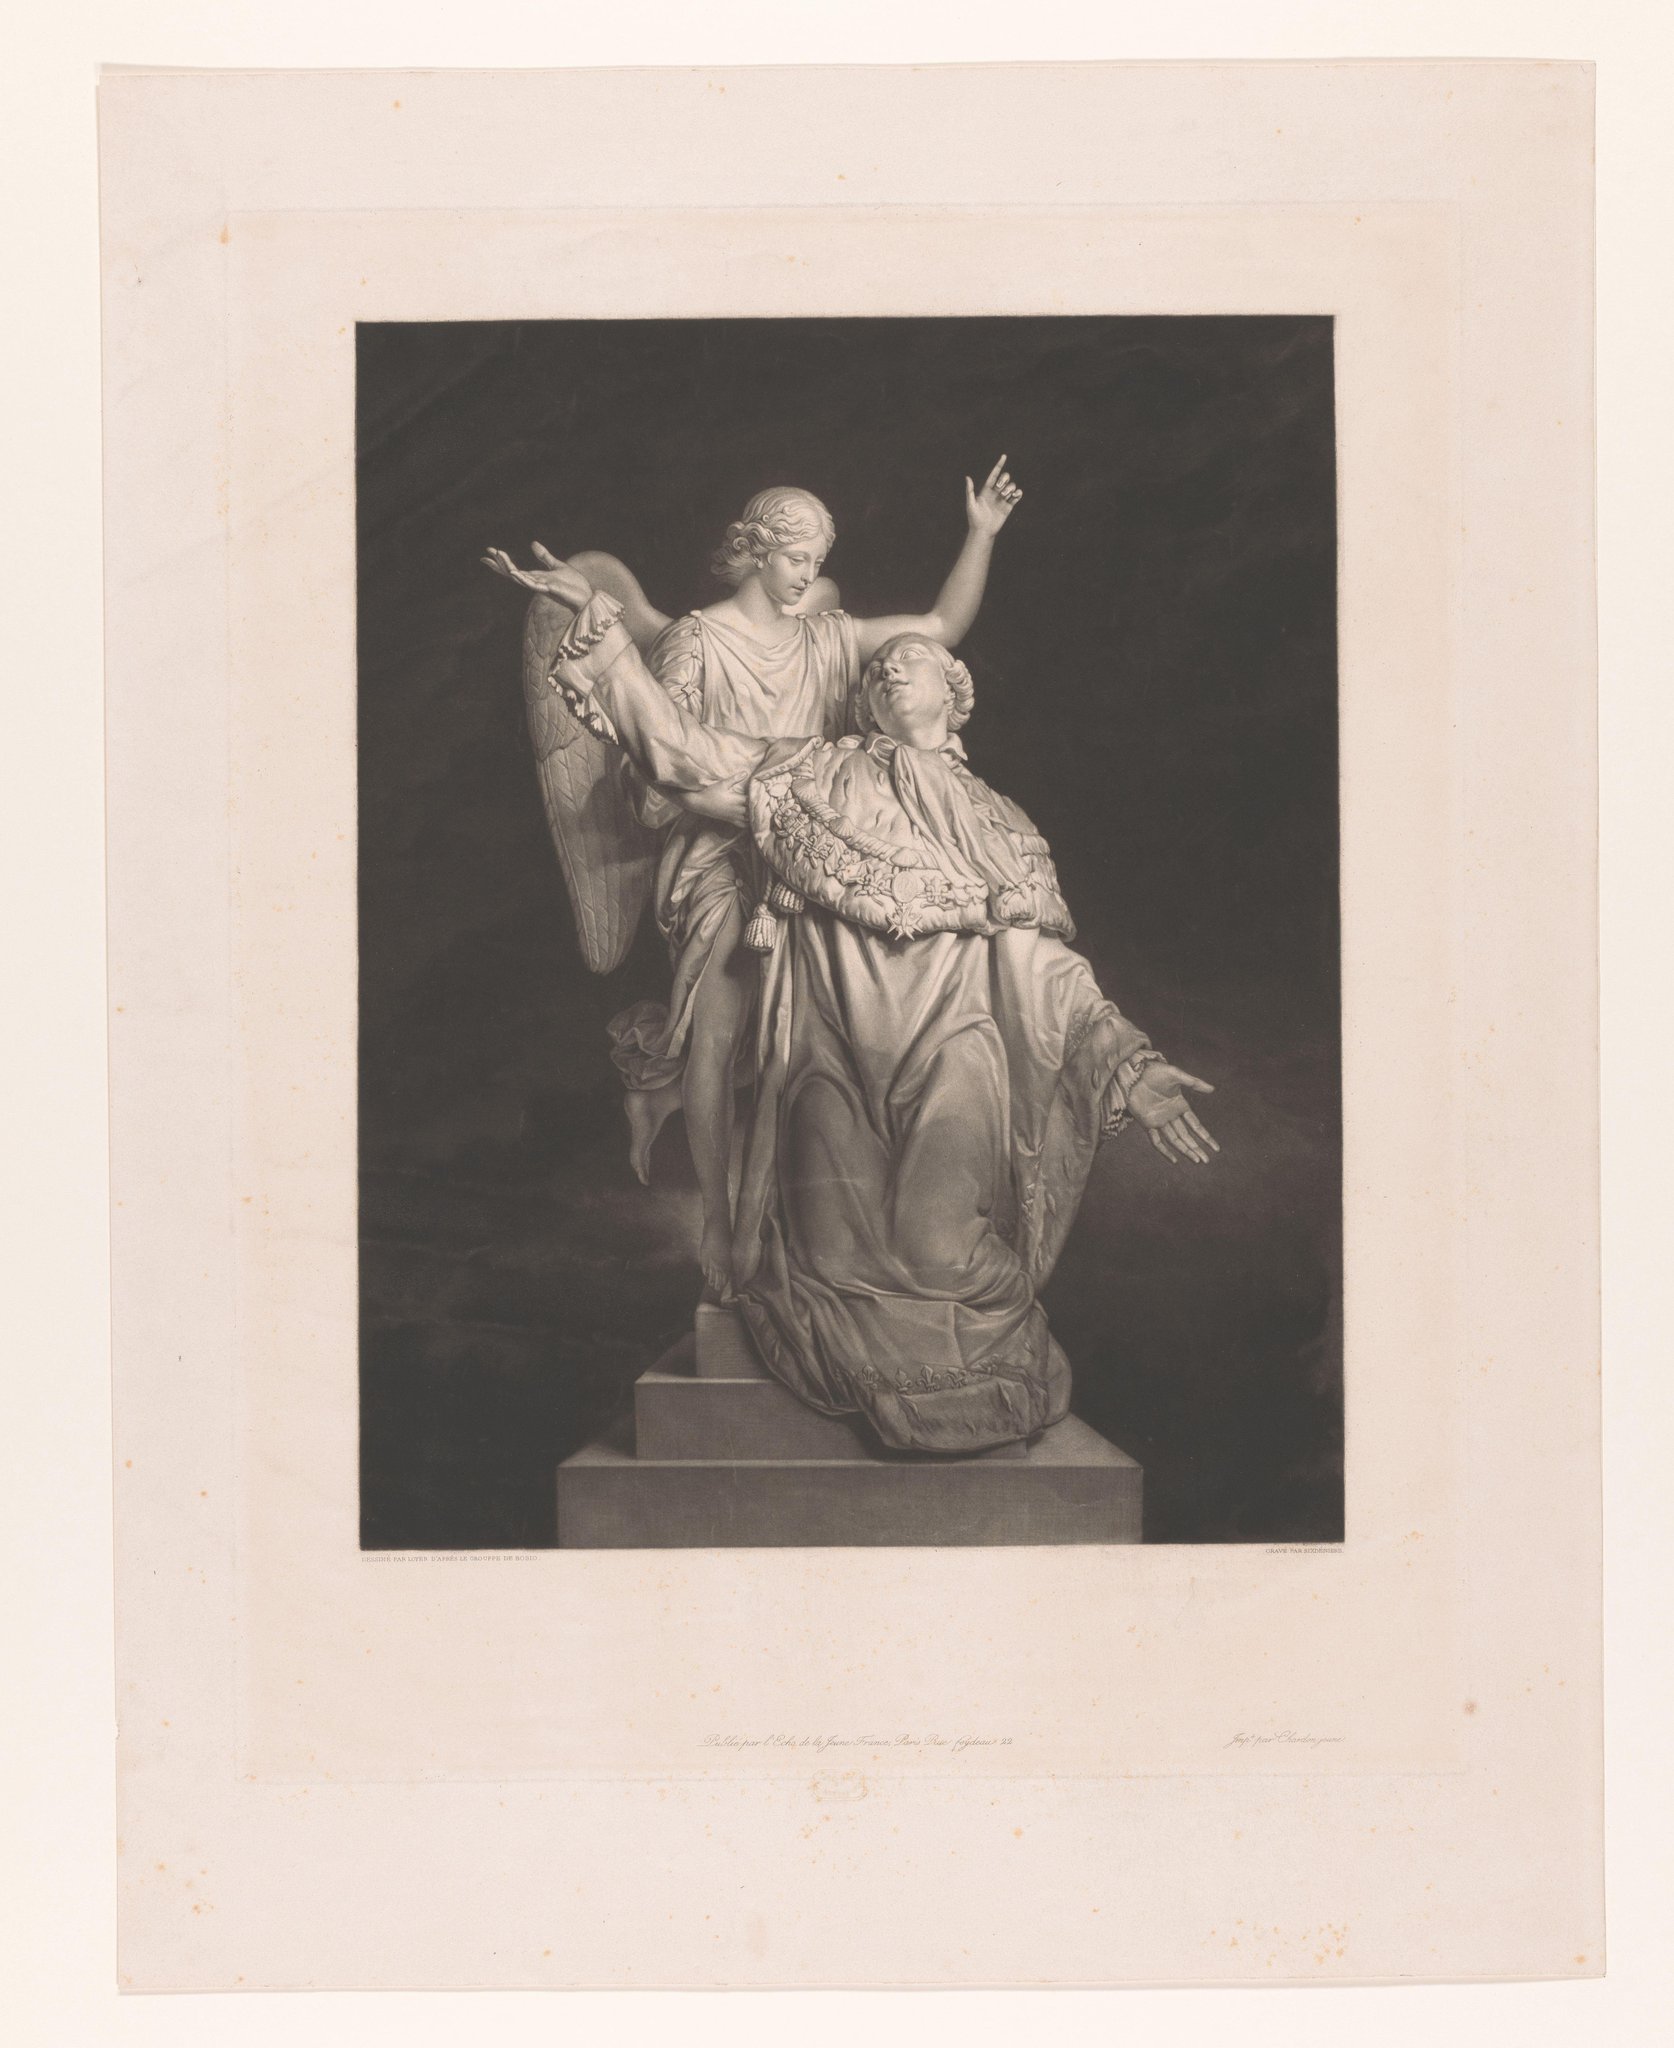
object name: print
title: Sculptuur van een knielende vorst met engel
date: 1803-1846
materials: paper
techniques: mezzotint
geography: france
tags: king, angels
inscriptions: collector's mark: Lugt 2165